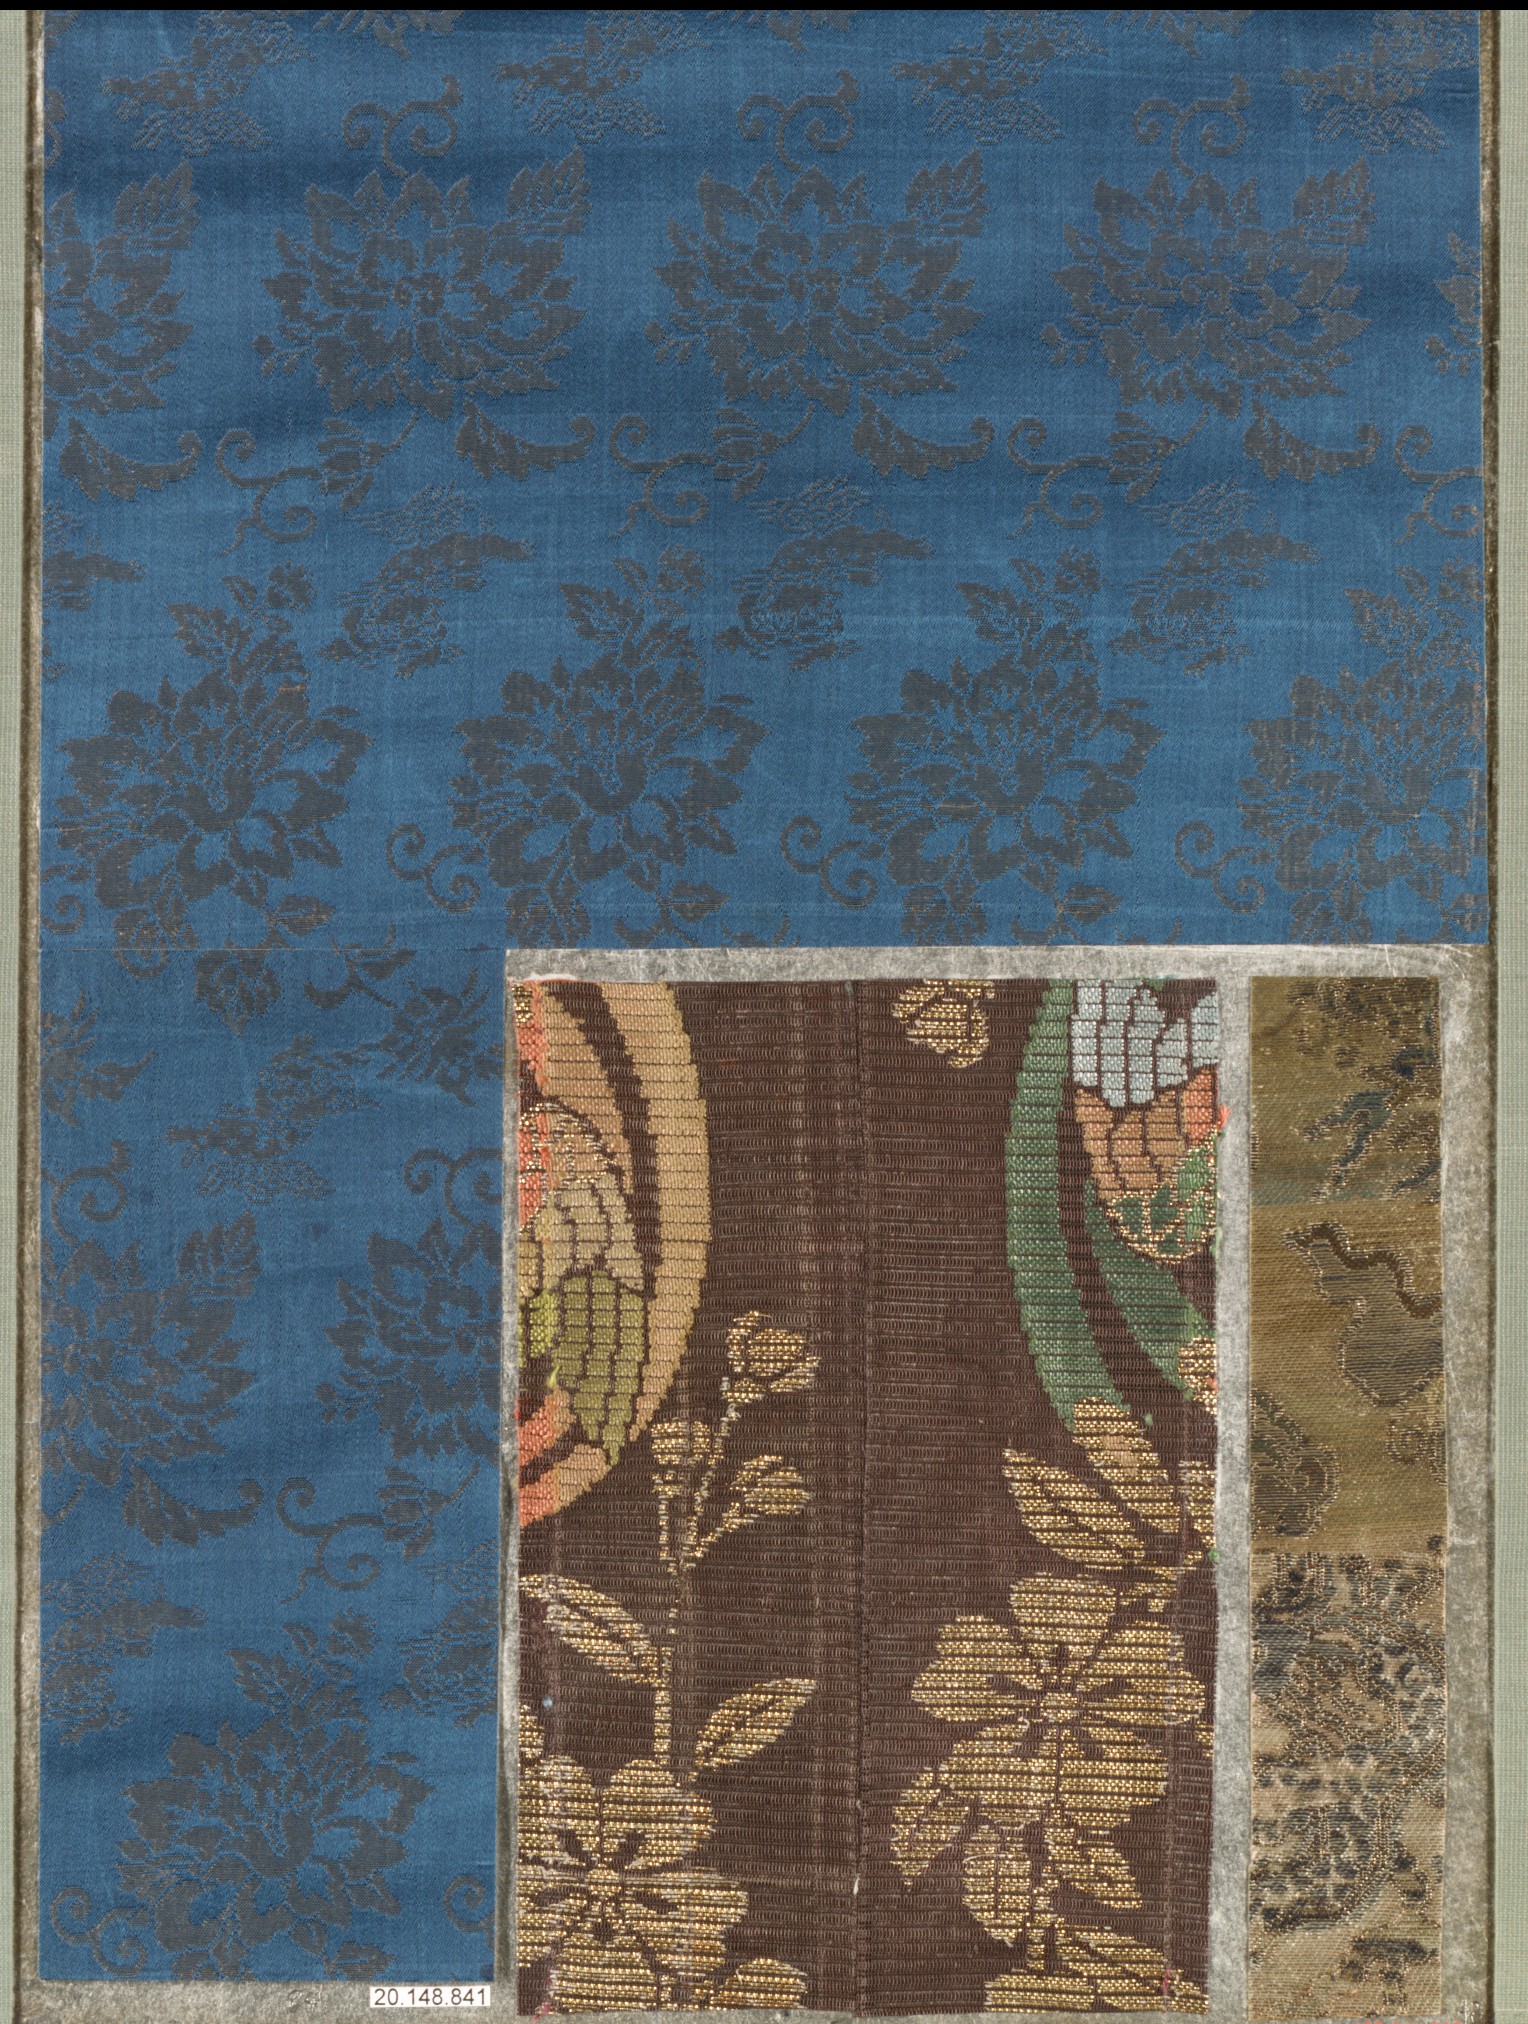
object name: piece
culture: japanese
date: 1701-1800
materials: silk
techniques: compound weave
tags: flowers